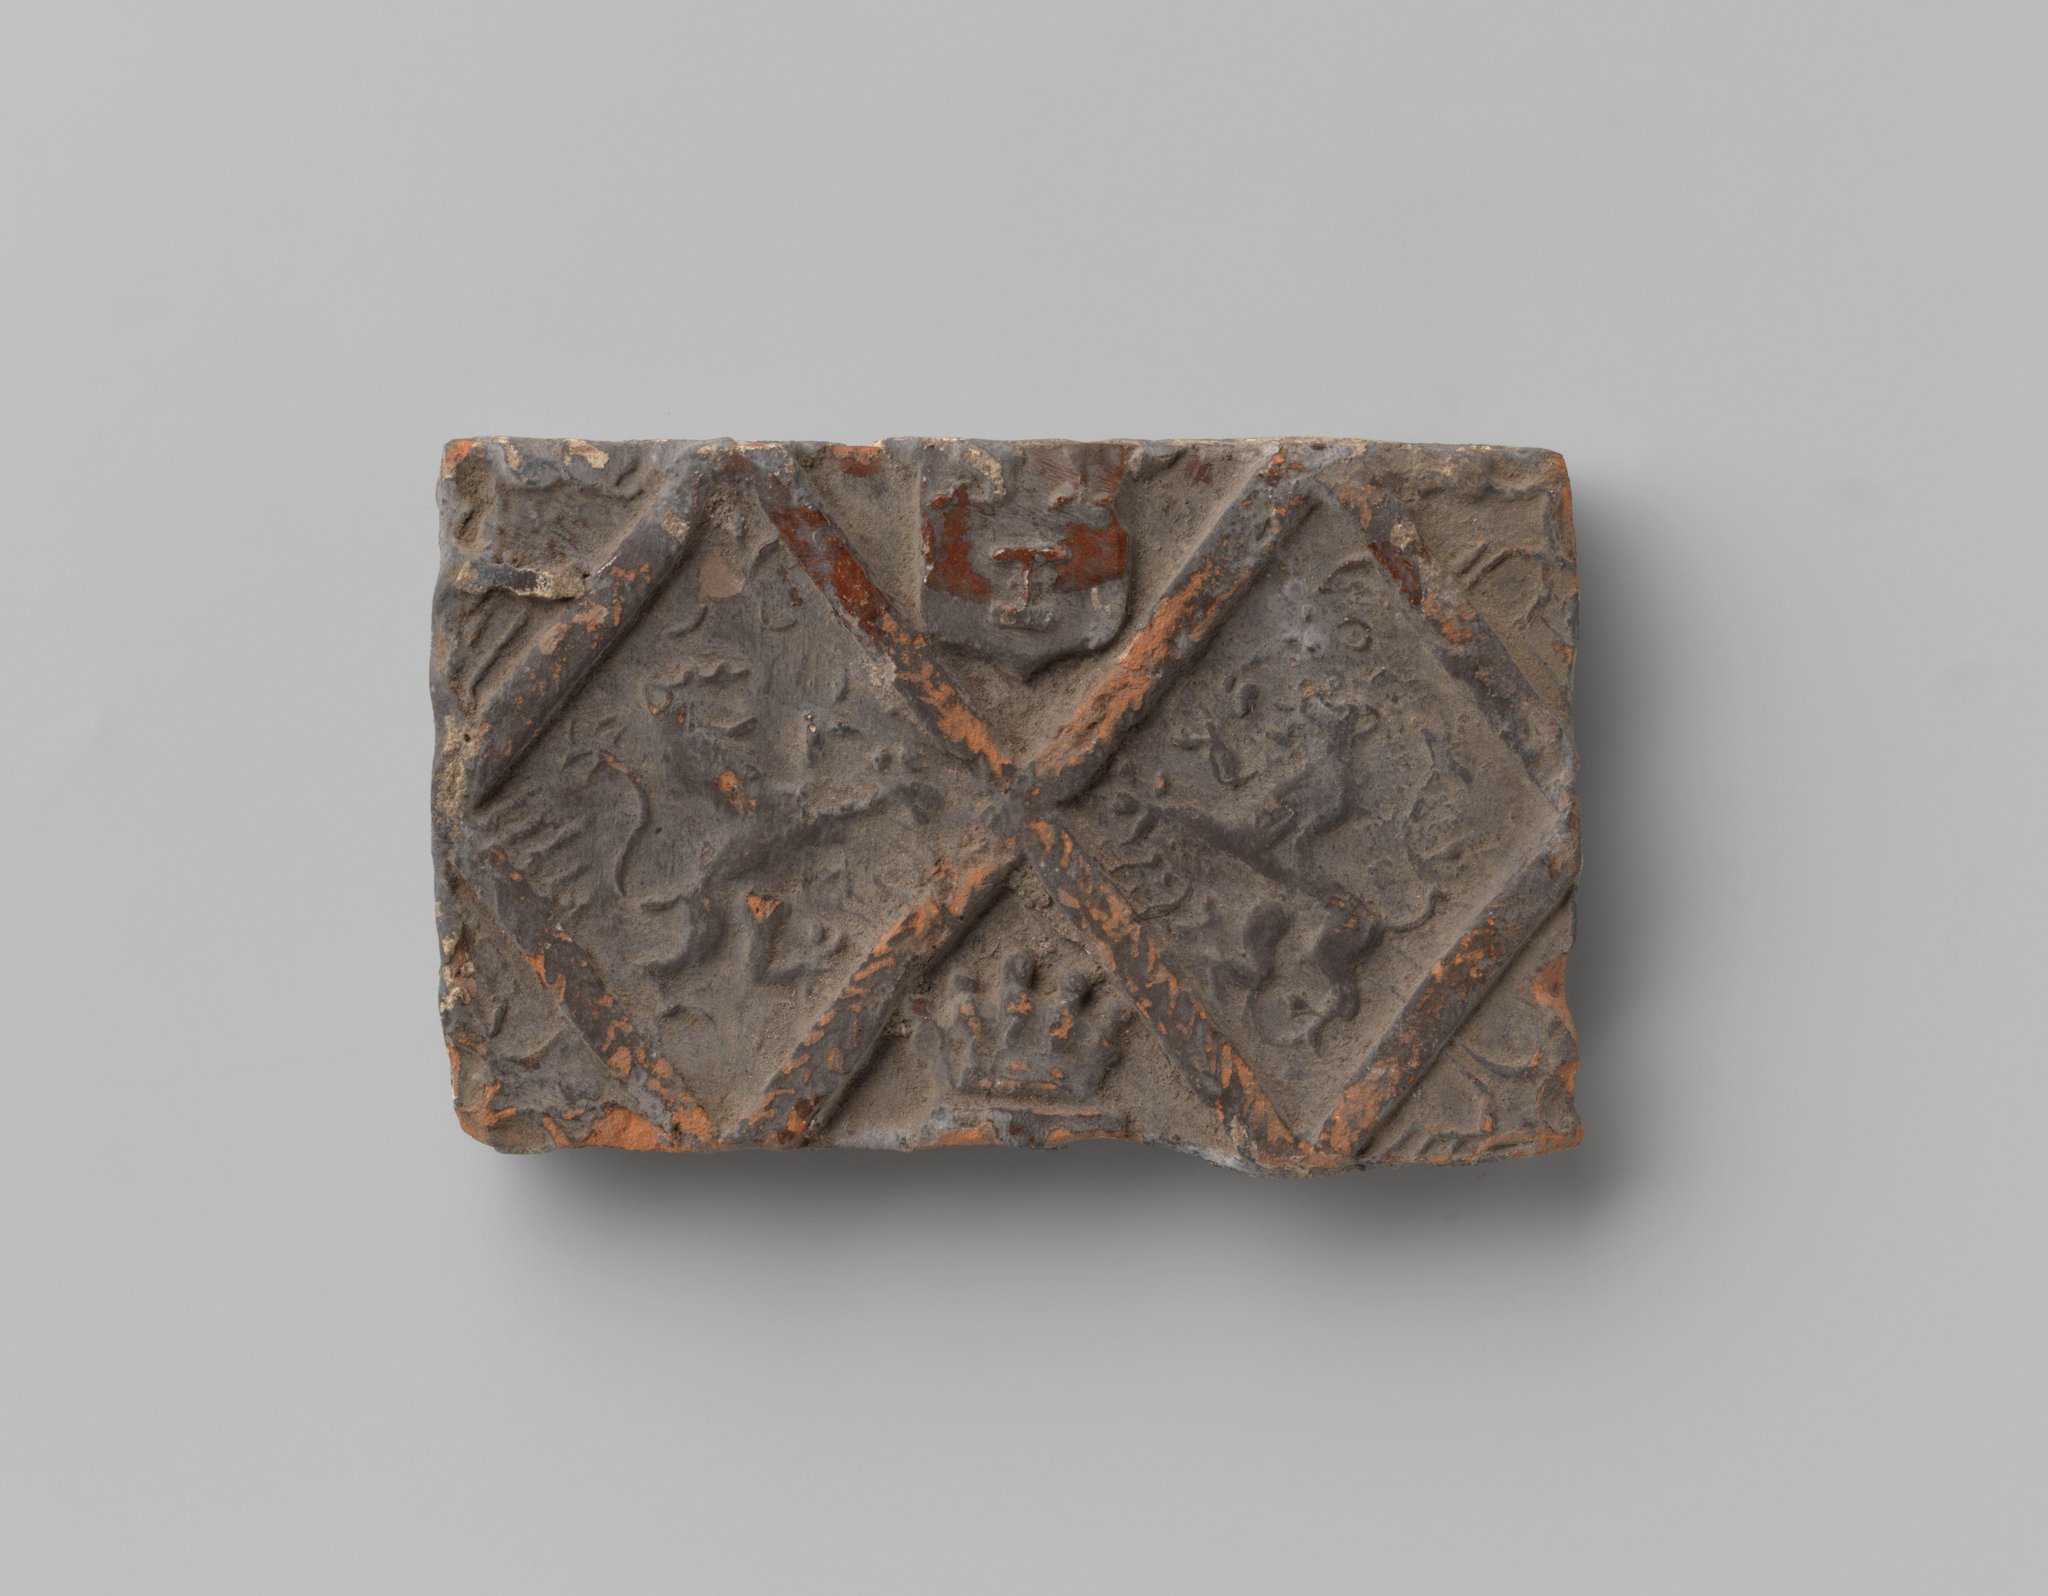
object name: hearthstone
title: Haardsteen met voorstelling van twee klimmende leeuwen en een wapenschild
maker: Anonymous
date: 1610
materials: earthenware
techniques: printing, firing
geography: southern netherlands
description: Haardsteen met voorstelling van twee klimmende leeuwen en het jaartal 1610, geplaatst in geprofileerde ruit. De halve ruiten aan de boven- en onderkant zijn opgevuld met een wapen, een kroon en stermotief.